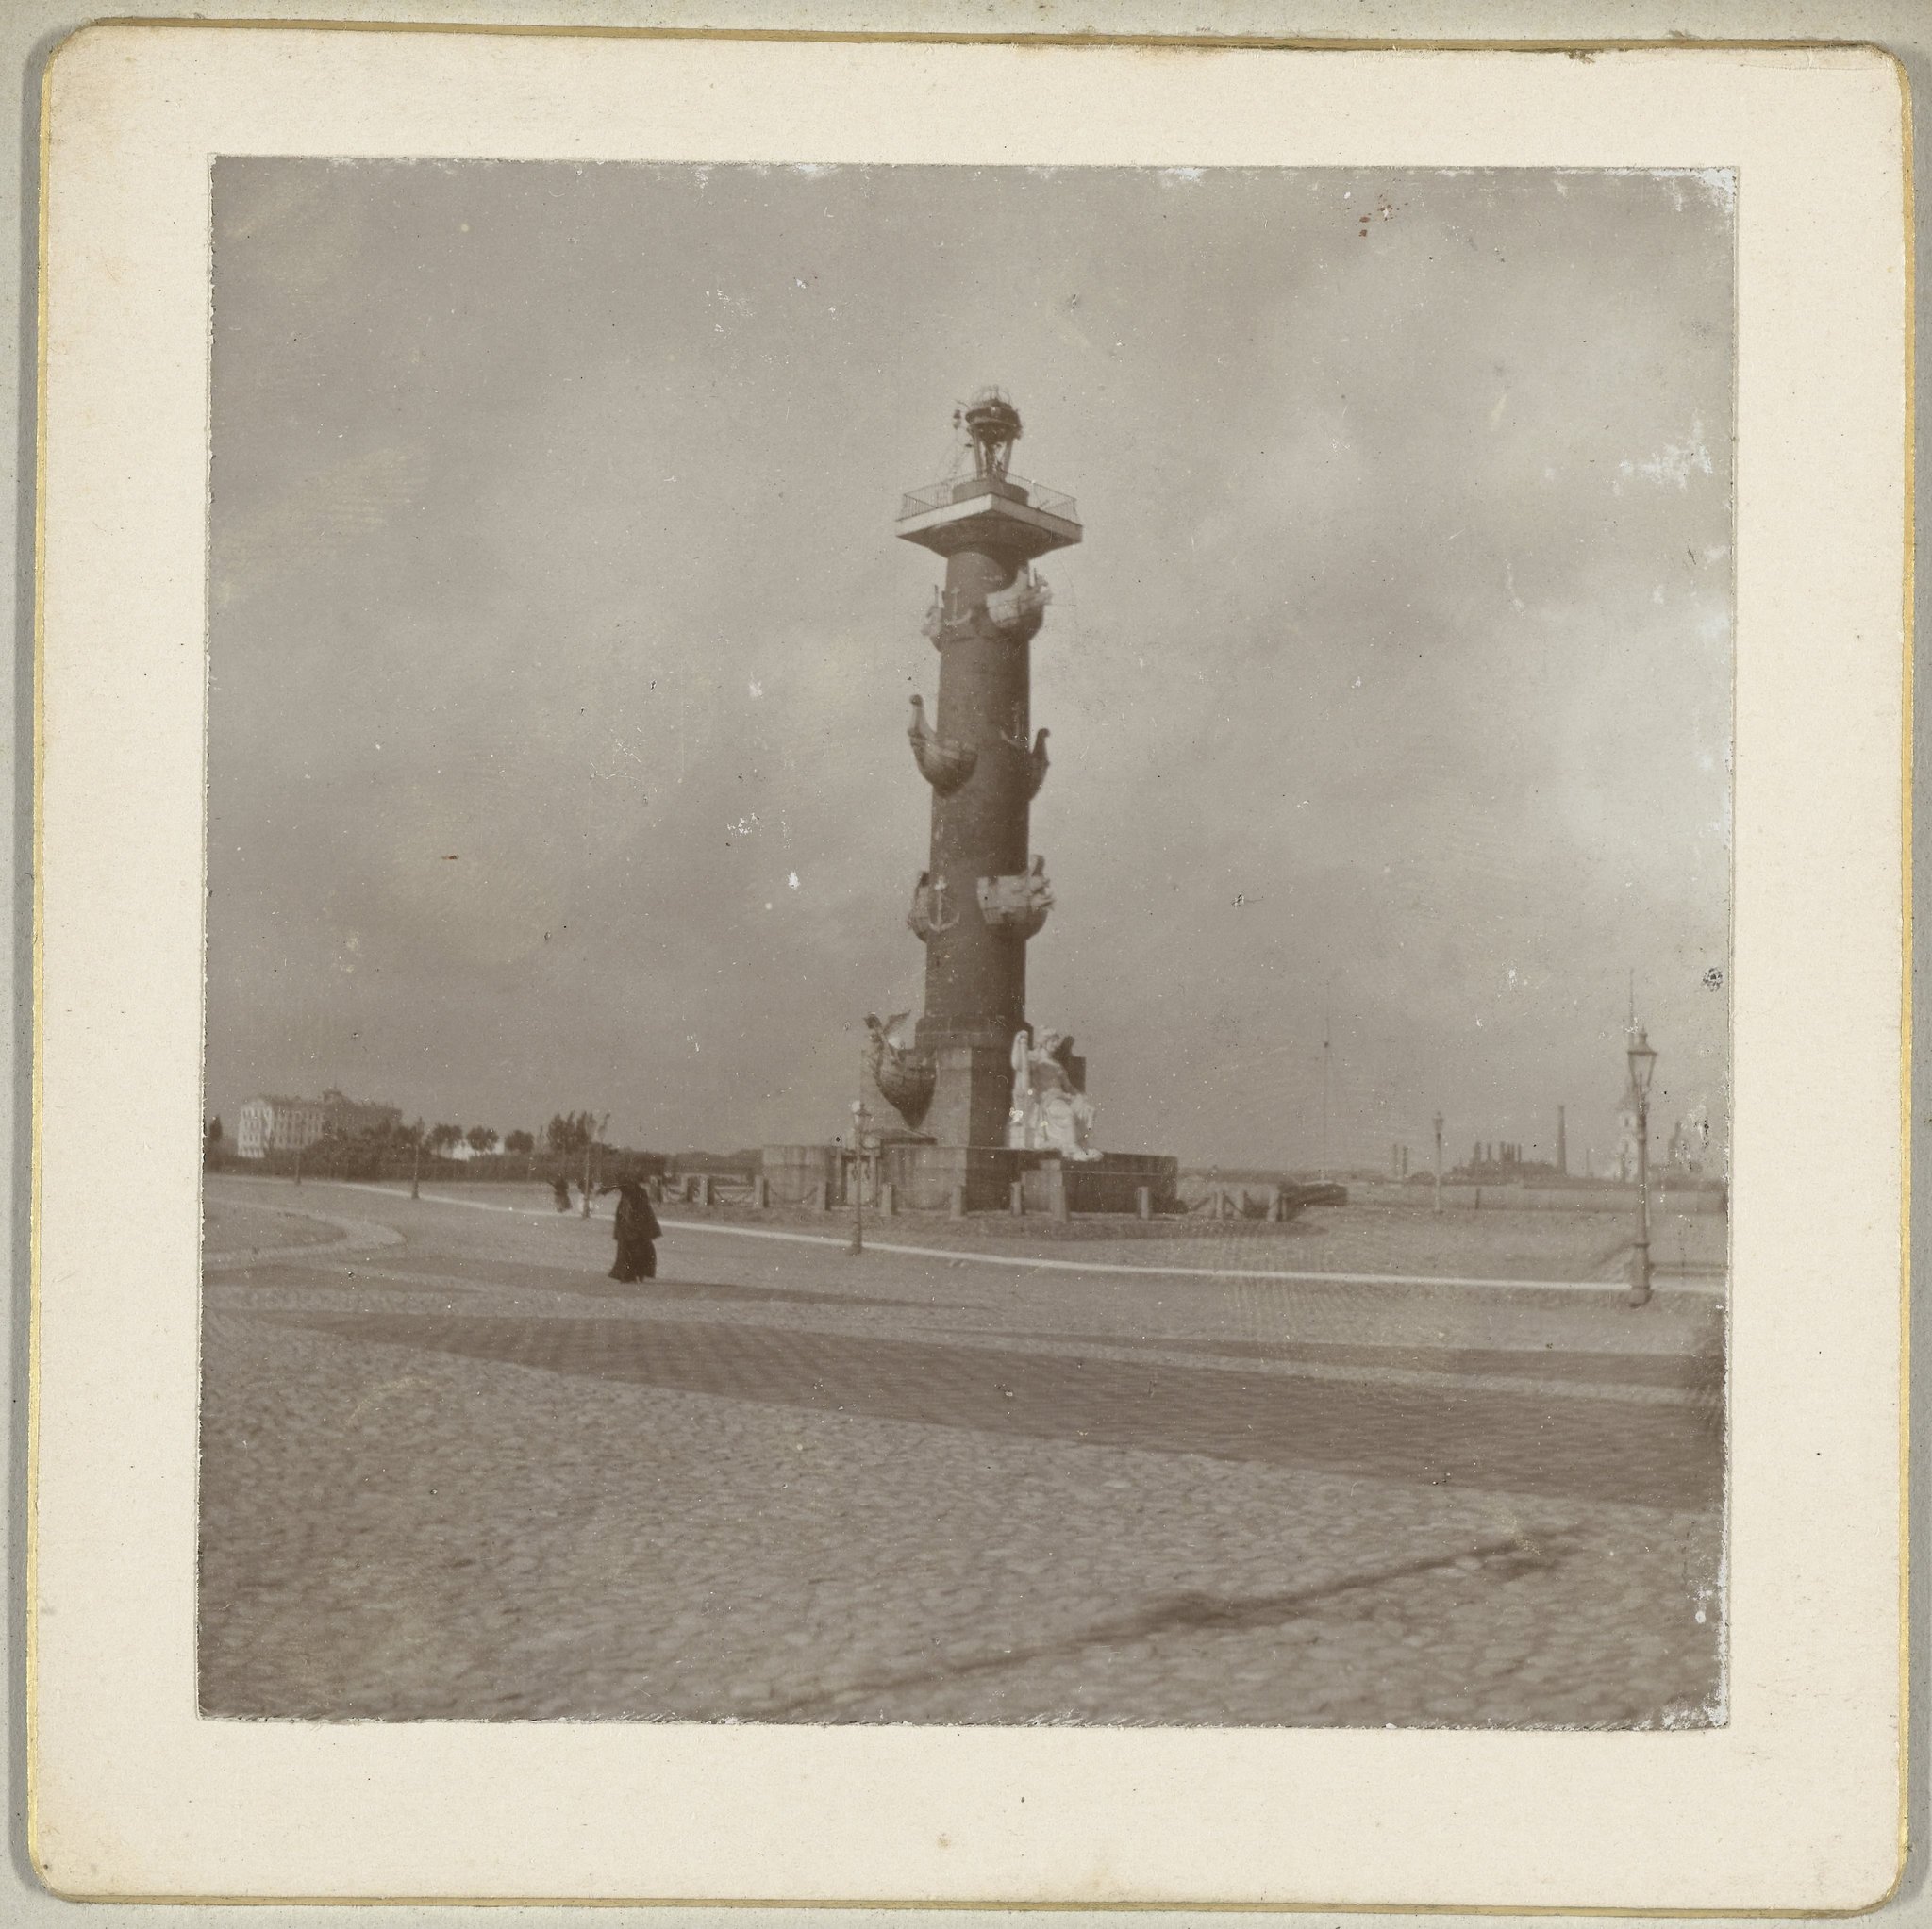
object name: photograph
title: Zuil aan het einde van een brug over de Neva in Sint-Petersburg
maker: henry pauw van wieldrecht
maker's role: fotograaf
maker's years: 1863-1912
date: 1898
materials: paper, photographic support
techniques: albumen print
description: Een zuil met uitstekende boegen van schepen op de brug over de Neva in Sint-Petersburg.